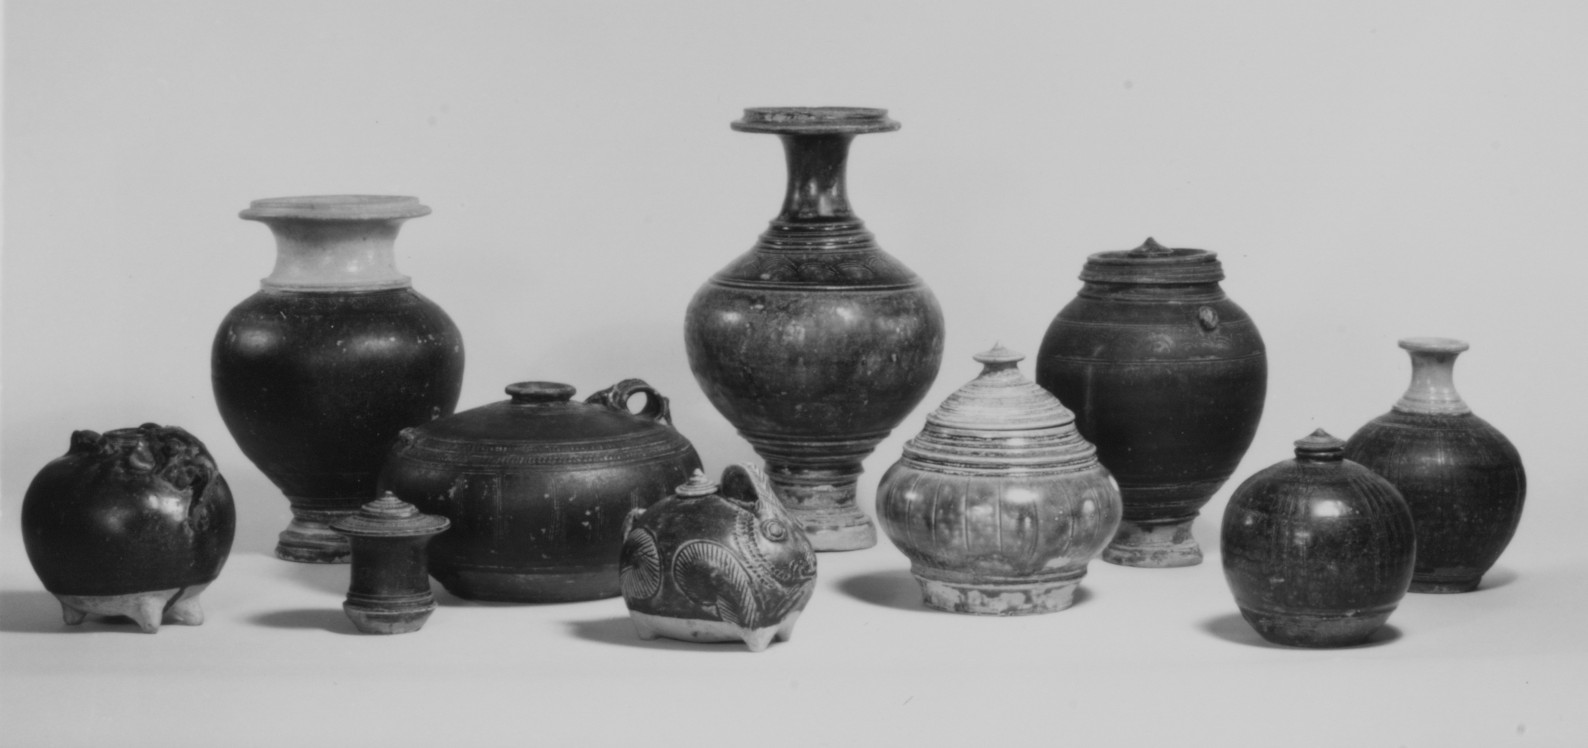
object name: covered jar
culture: thai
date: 1034-1200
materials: stoneware